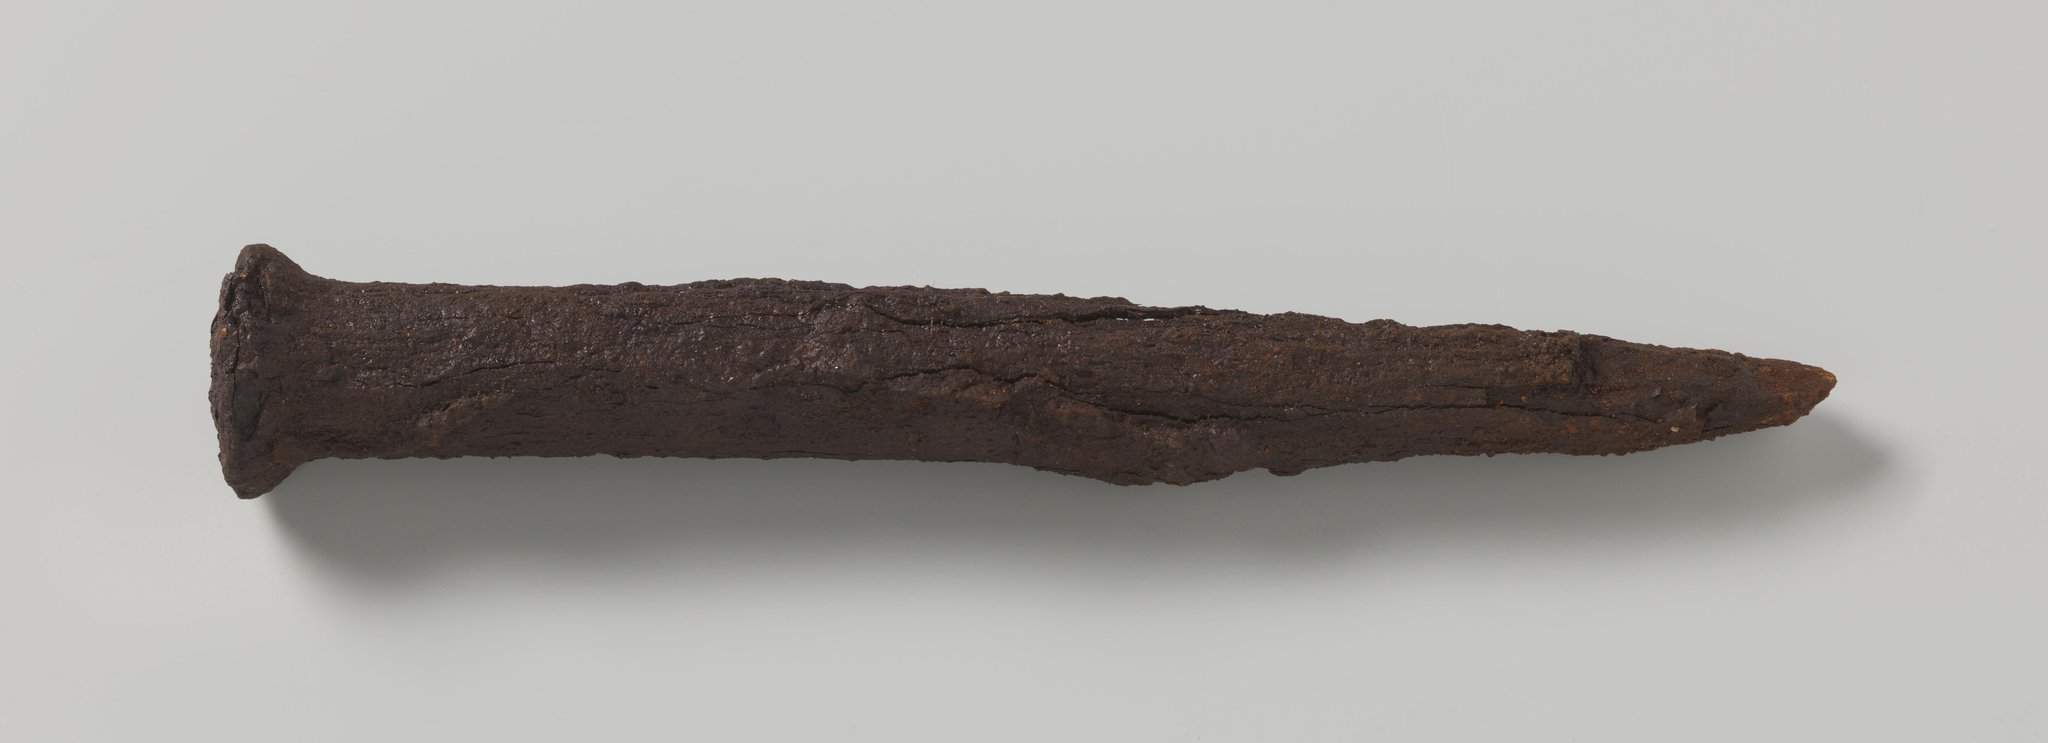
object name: nagel, spijker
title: Spijker uit het wrak van de Oostindiëvaarder Hollandia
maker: Anonymous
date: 1700-1743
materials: iron